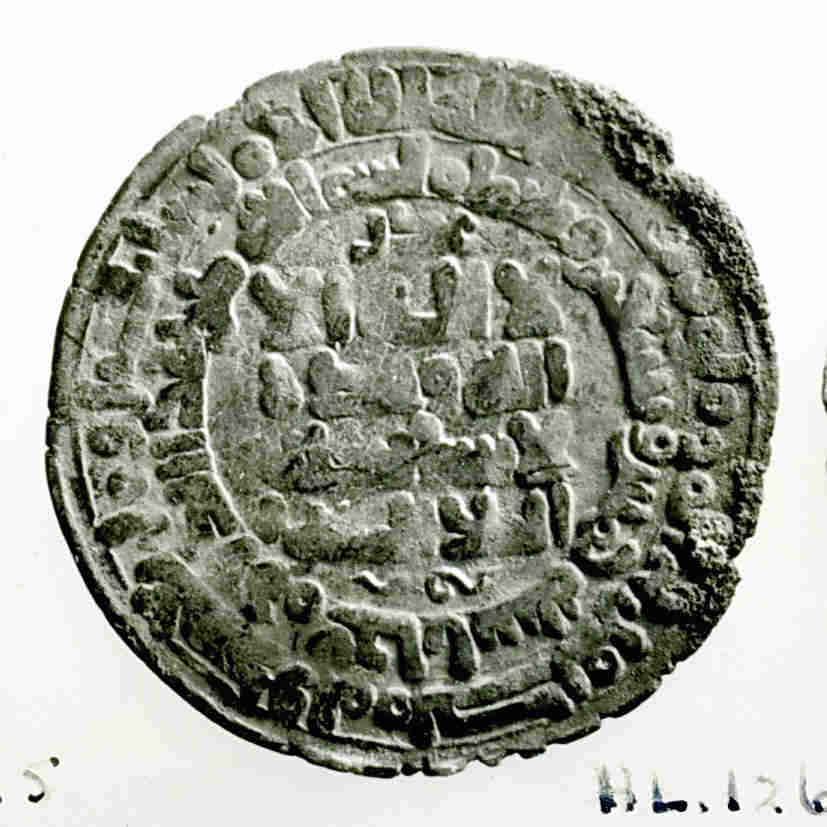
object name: coin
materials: silver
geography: uzbekistan